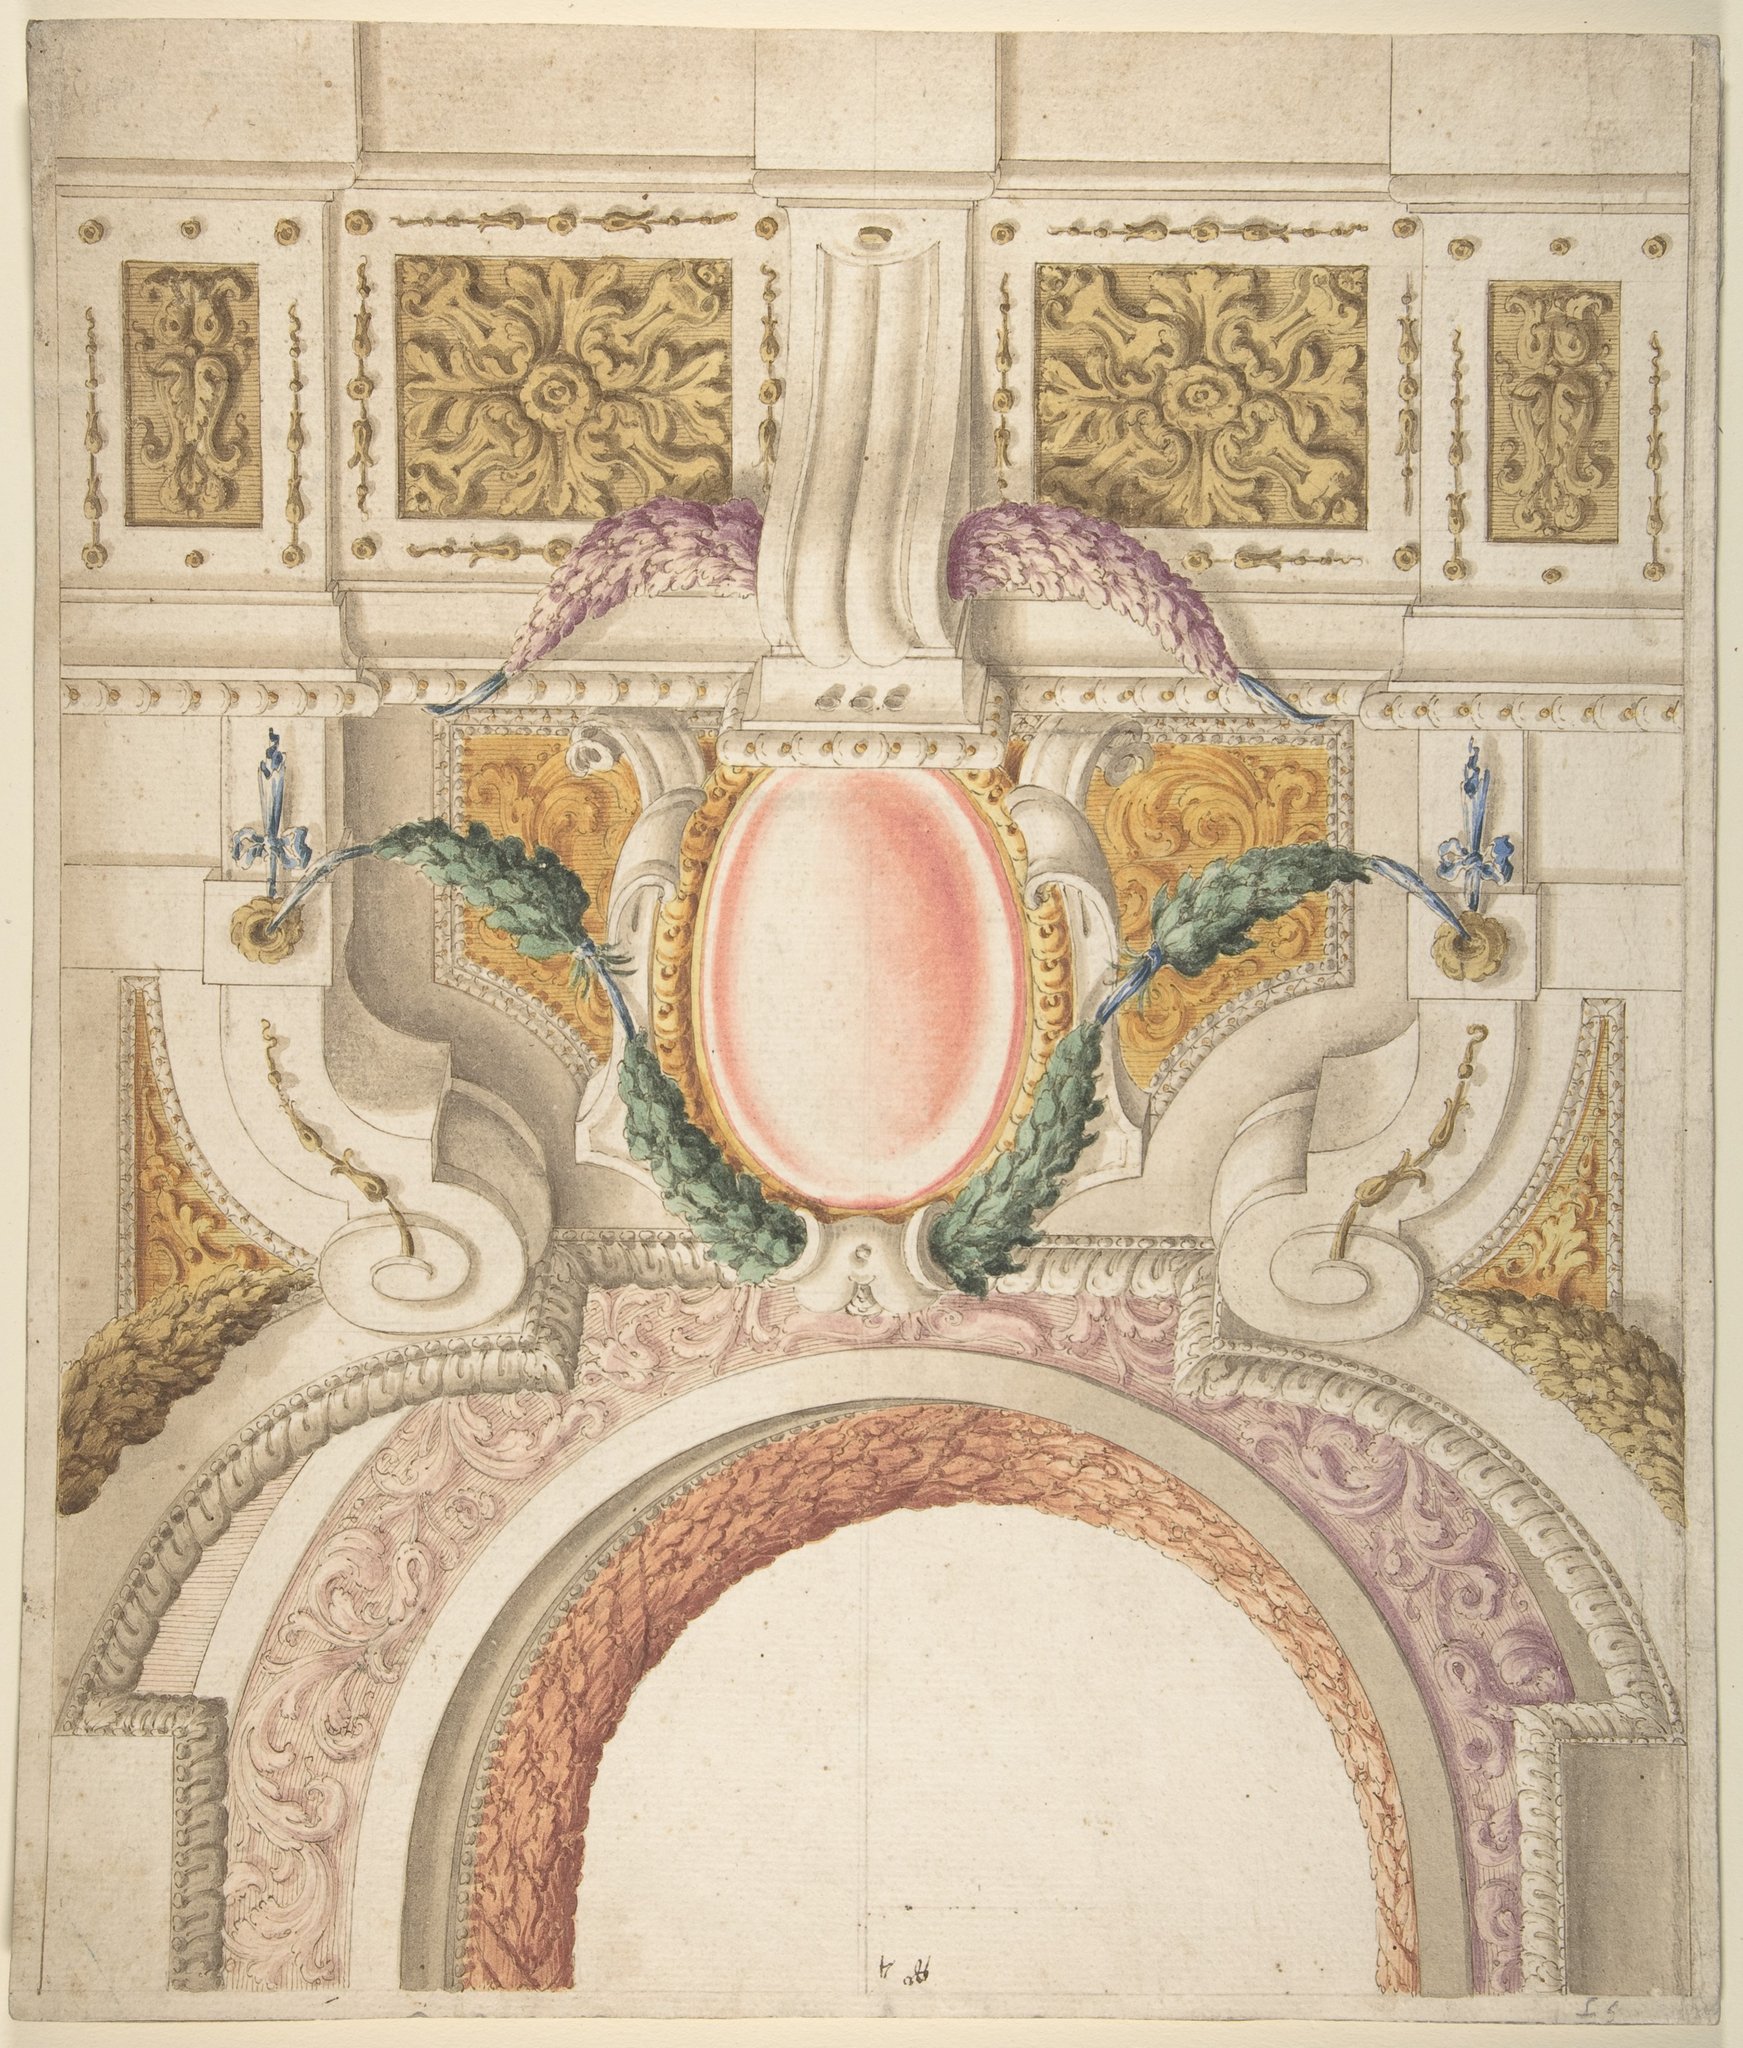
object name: drawing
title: Design for a Part of a Ceiling and a Pediment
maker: anonymous, italian, 18th century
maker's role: artist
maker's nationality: italian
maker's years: 1700-1800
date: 1701-1800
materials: chalk, ink, paper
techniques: brush, pen, wash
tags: ceilings